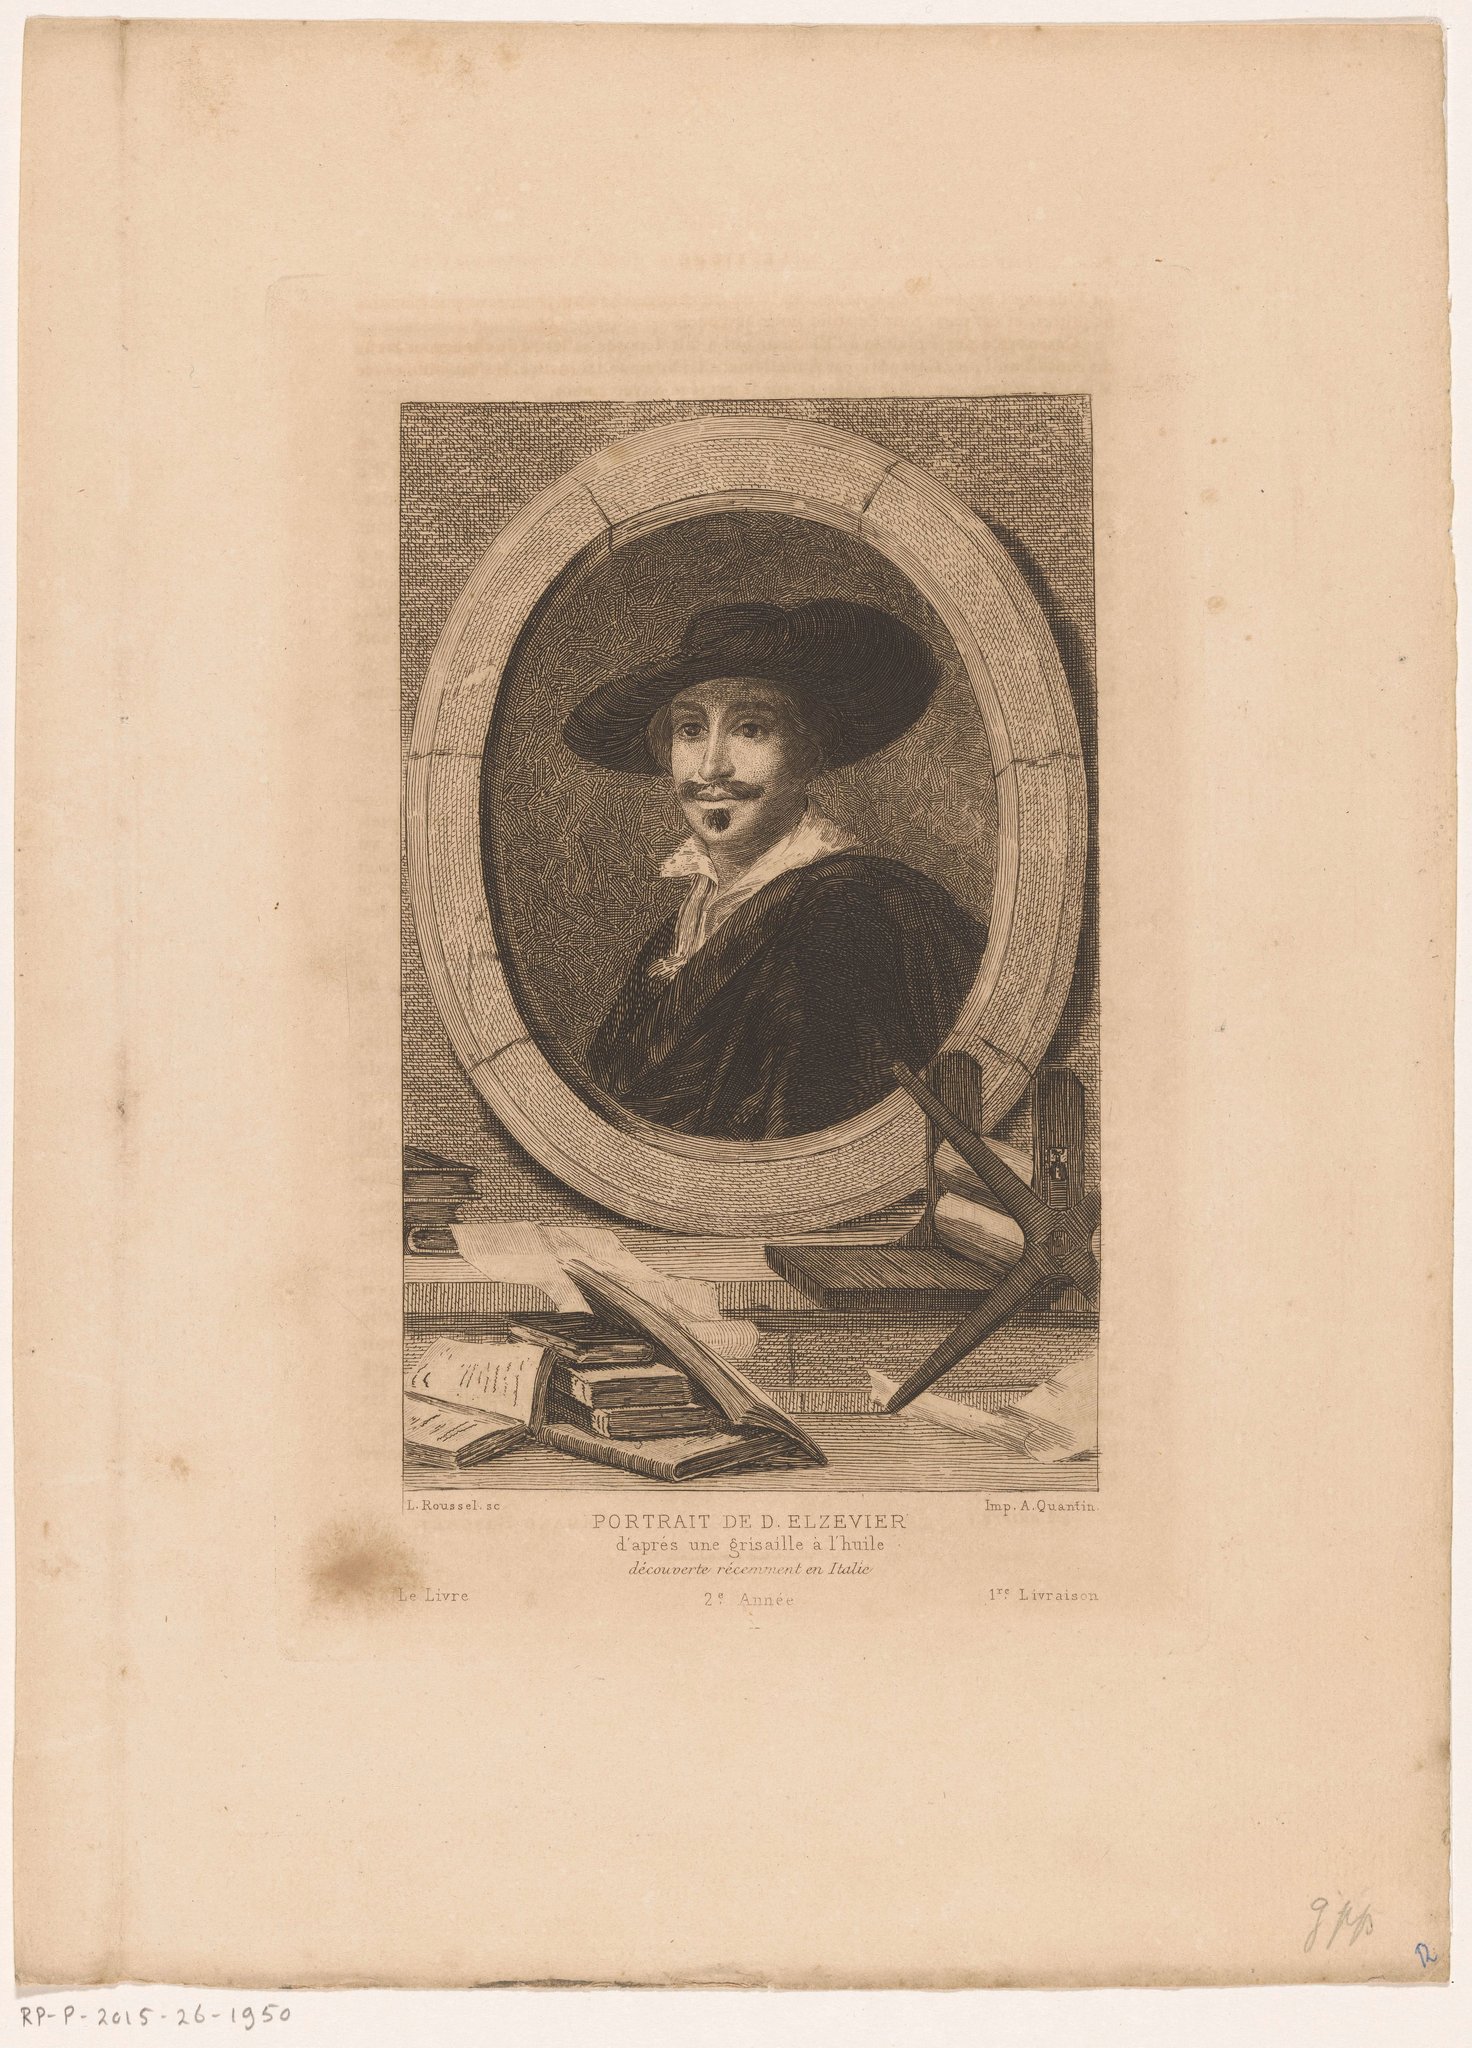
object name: print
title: Portret van Daniel Elzevier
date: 1881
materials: paper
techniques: etching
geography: paris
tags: leiden, publisher, daniel elzevier, tools, implements of graphic artist, book, publishing, publisher, printer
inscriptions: collector's mark: Lugt 4779, collector's mark: Lugt 2228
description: Portret van Daniel Elzevier, boekdrukker en uitgever te Leiden en Amsterdam. Ovaal portret in een architecturale omlijsting met onder stapels boeken en een plaatpers.